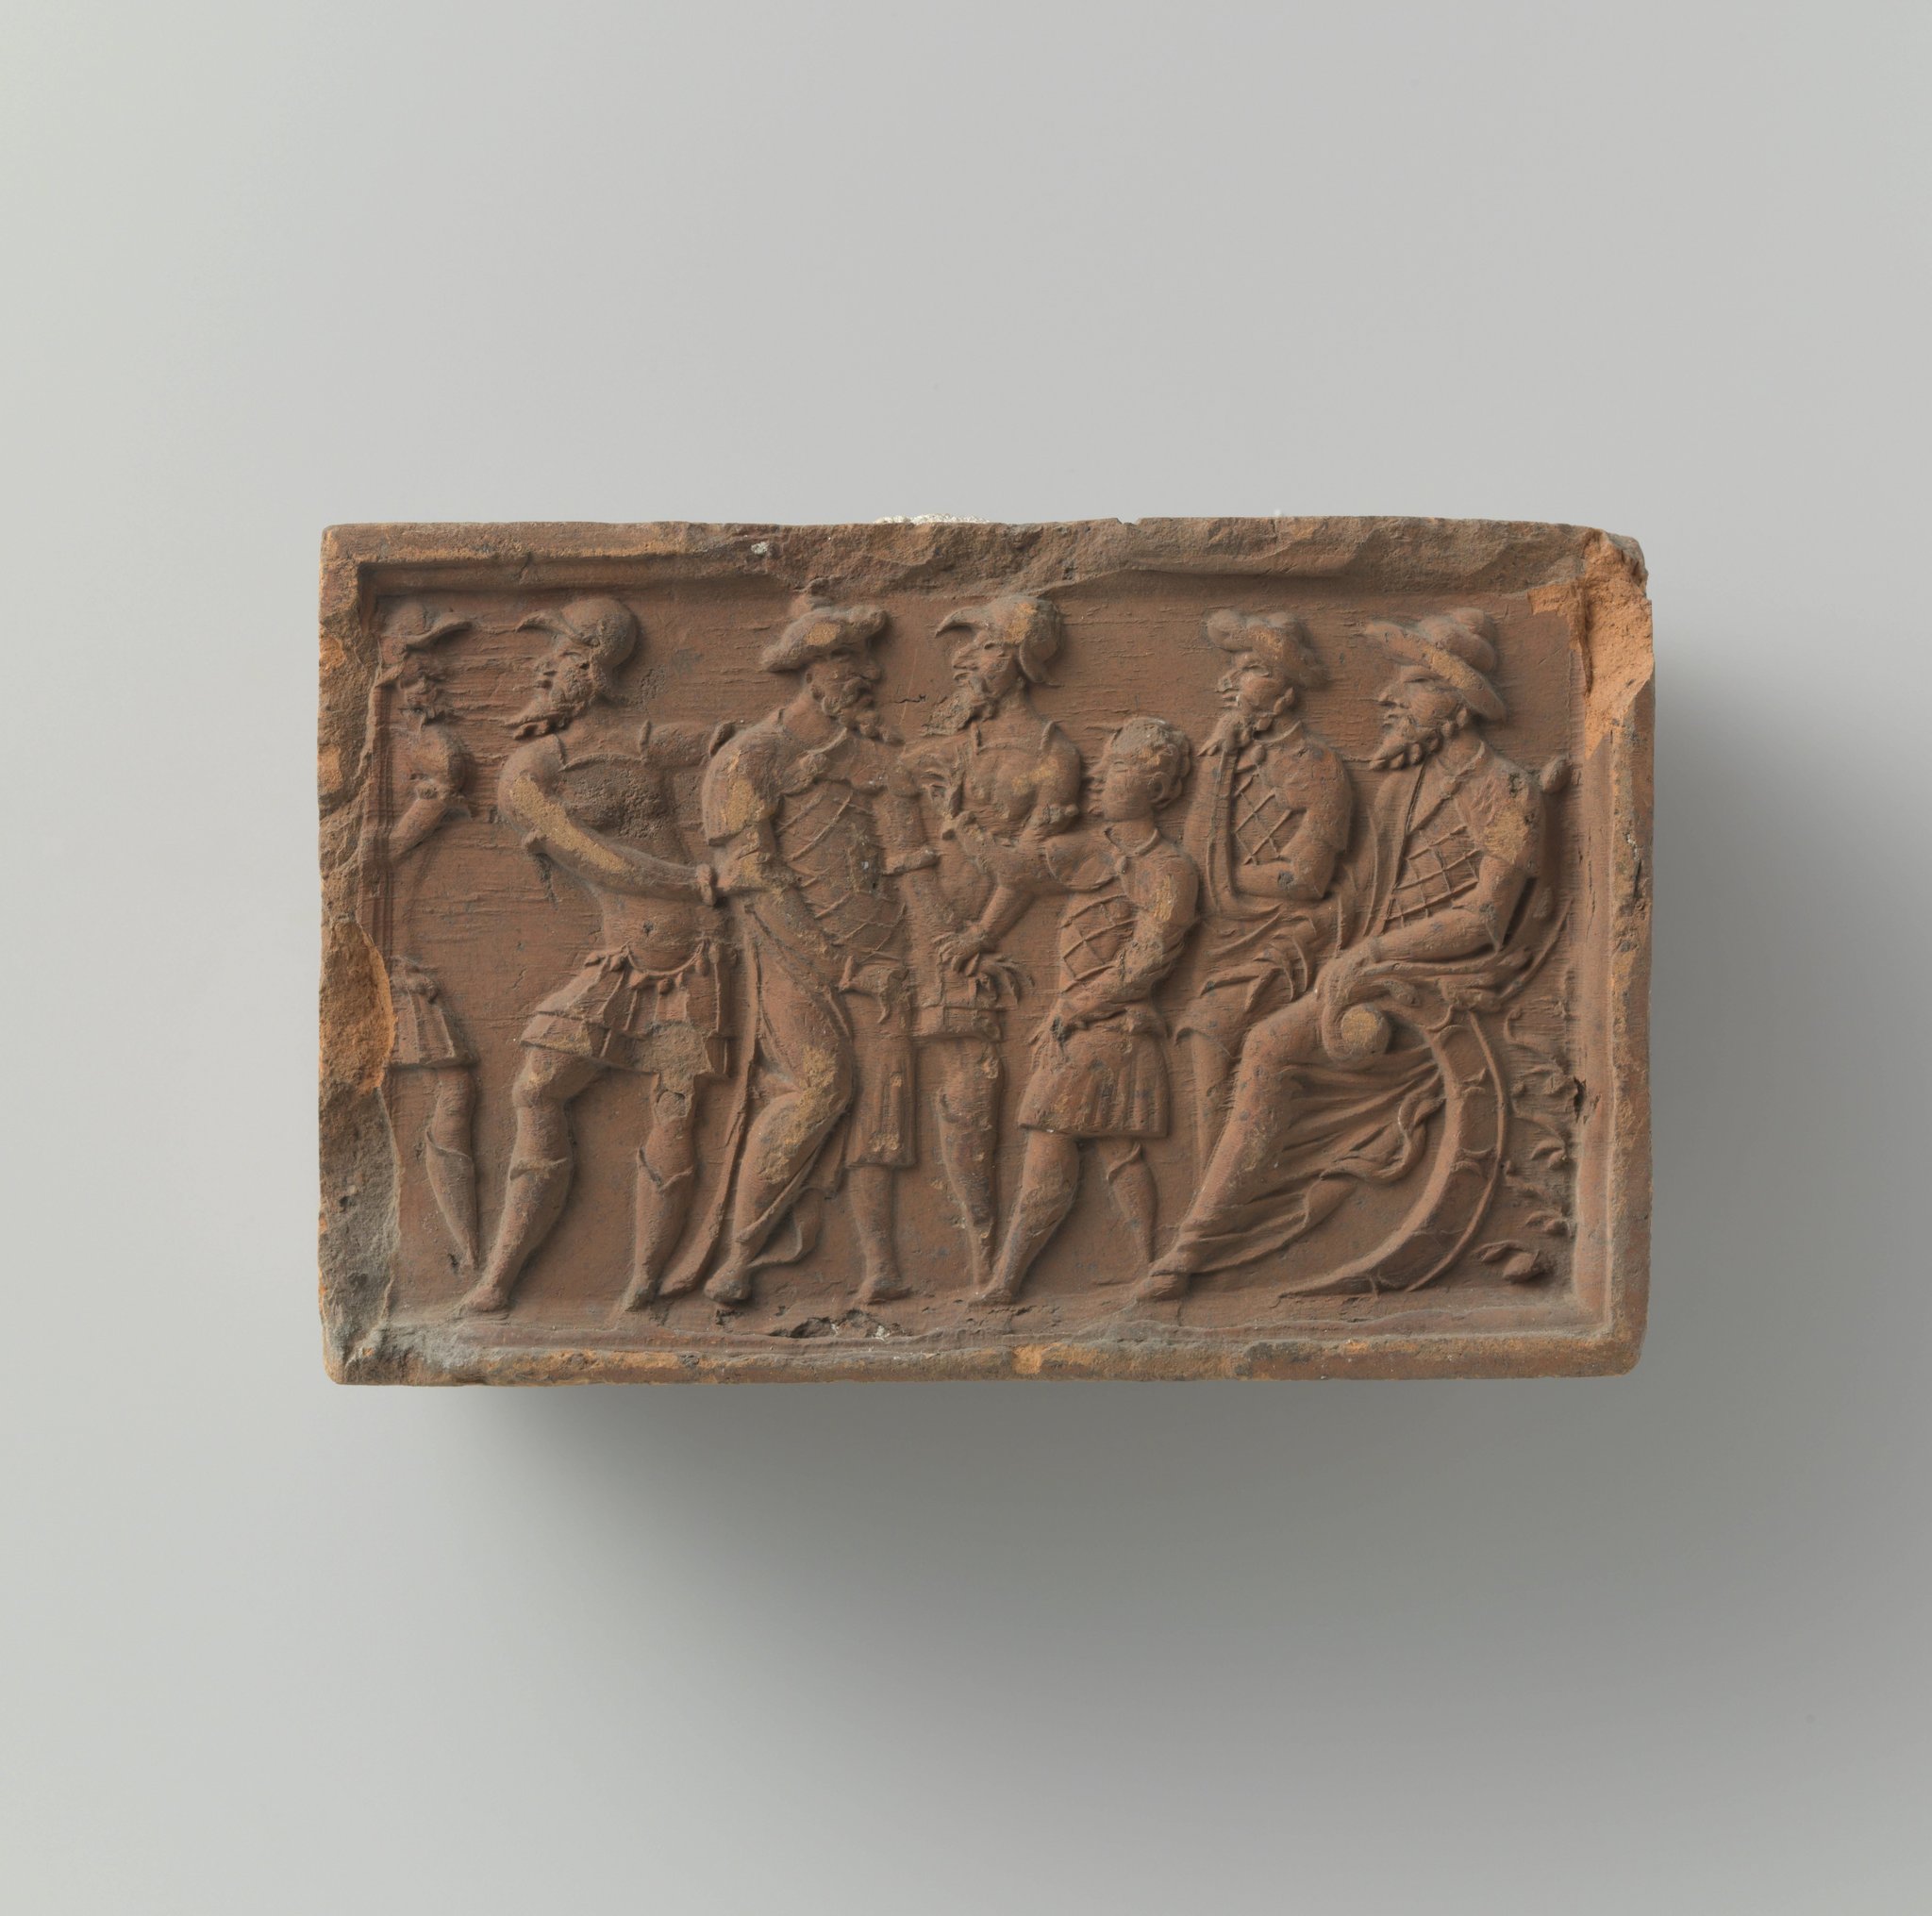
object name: hearthstone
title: Haardsteen met voorstelling van Daniël, die de beide ouderlingen uit de geschiedenis van Suzanna afzonderlijk aan een verhoor onderwerpt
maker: Anonymous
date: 1550-1600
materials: earthenware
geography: southern netherlands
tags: daniel interrogates the elders separately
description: Haardsteen met voorstelling van Daniël, die de beide ouderlingen uit de geschiedenis van Suzanna afzonderlijk aan een verhoor onderwerpt.